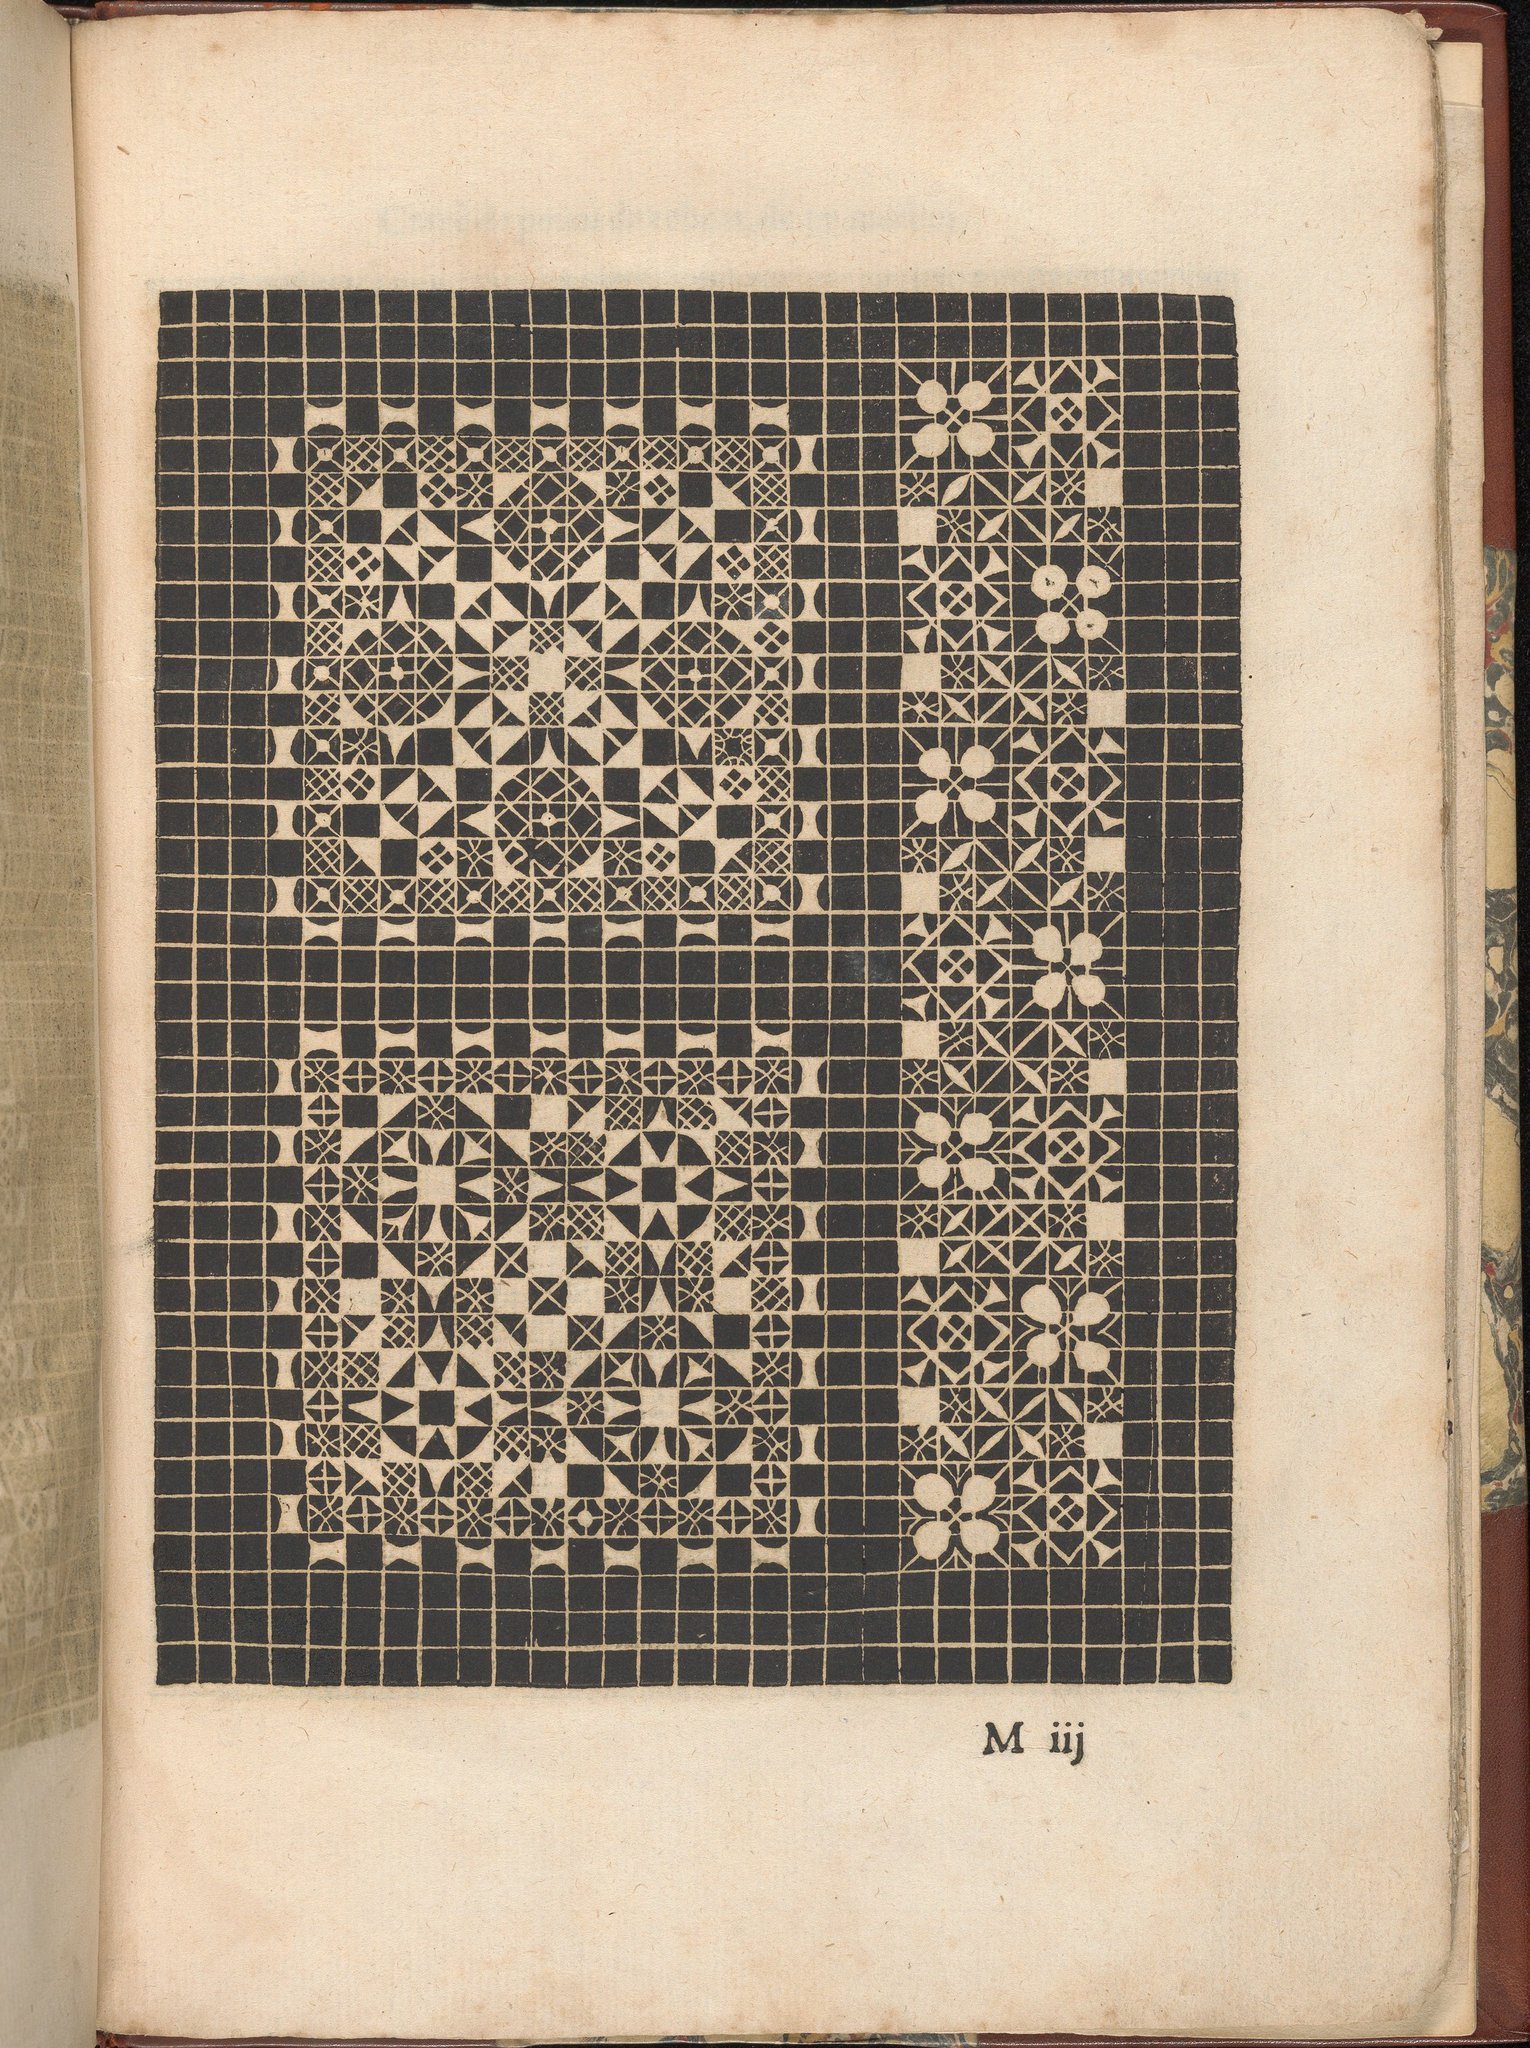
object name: book print ornament architecture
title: Les Secondes Oeuvres, et Subtiles Inventions De Lingerie du Seigneur Federic de Vinciolo Venitien, page 47 (recto)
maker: federico de vinciolo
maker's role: designer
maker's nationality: italian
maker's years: 1582-1599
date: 1603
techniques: woodcut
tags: ornament